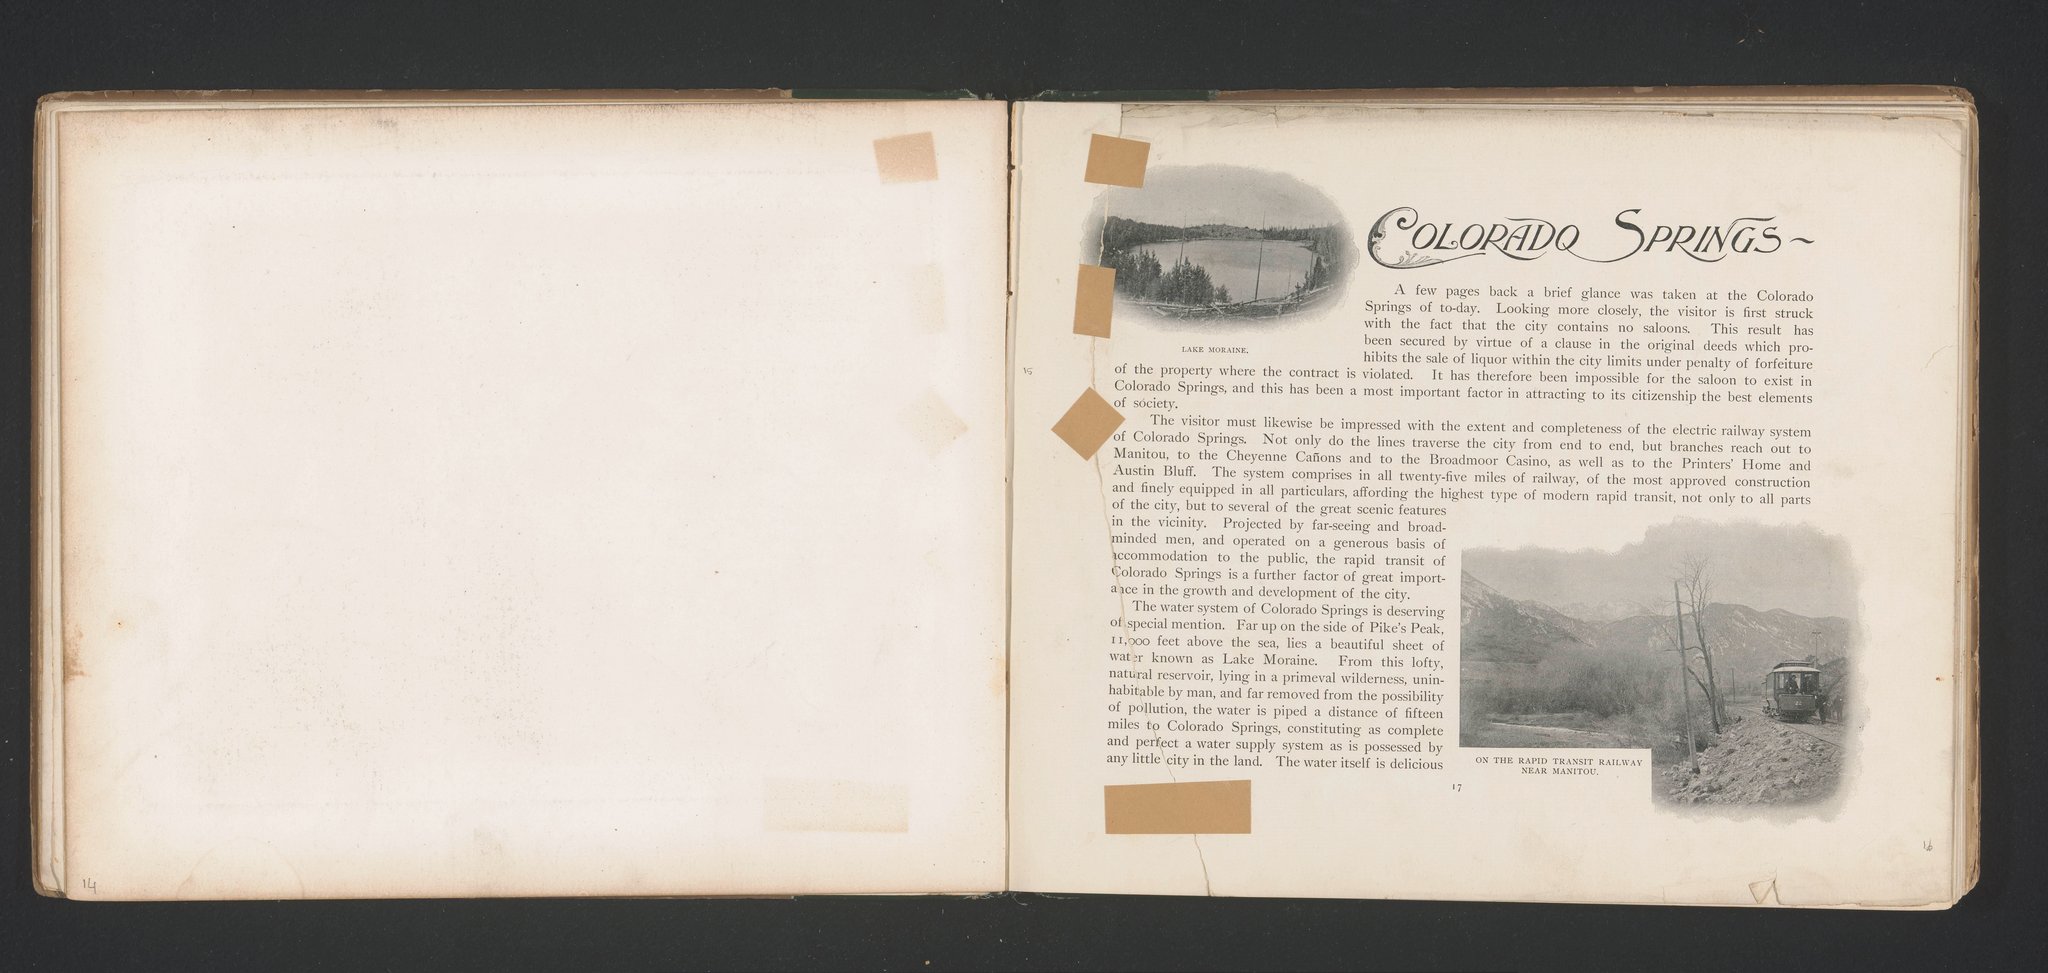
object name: photomechanical print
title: Gezicht op Lake Moraine te Colorado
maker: Anonymous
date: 1888-1893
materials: paper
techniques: autotype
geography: colorado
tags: landscapes, lake